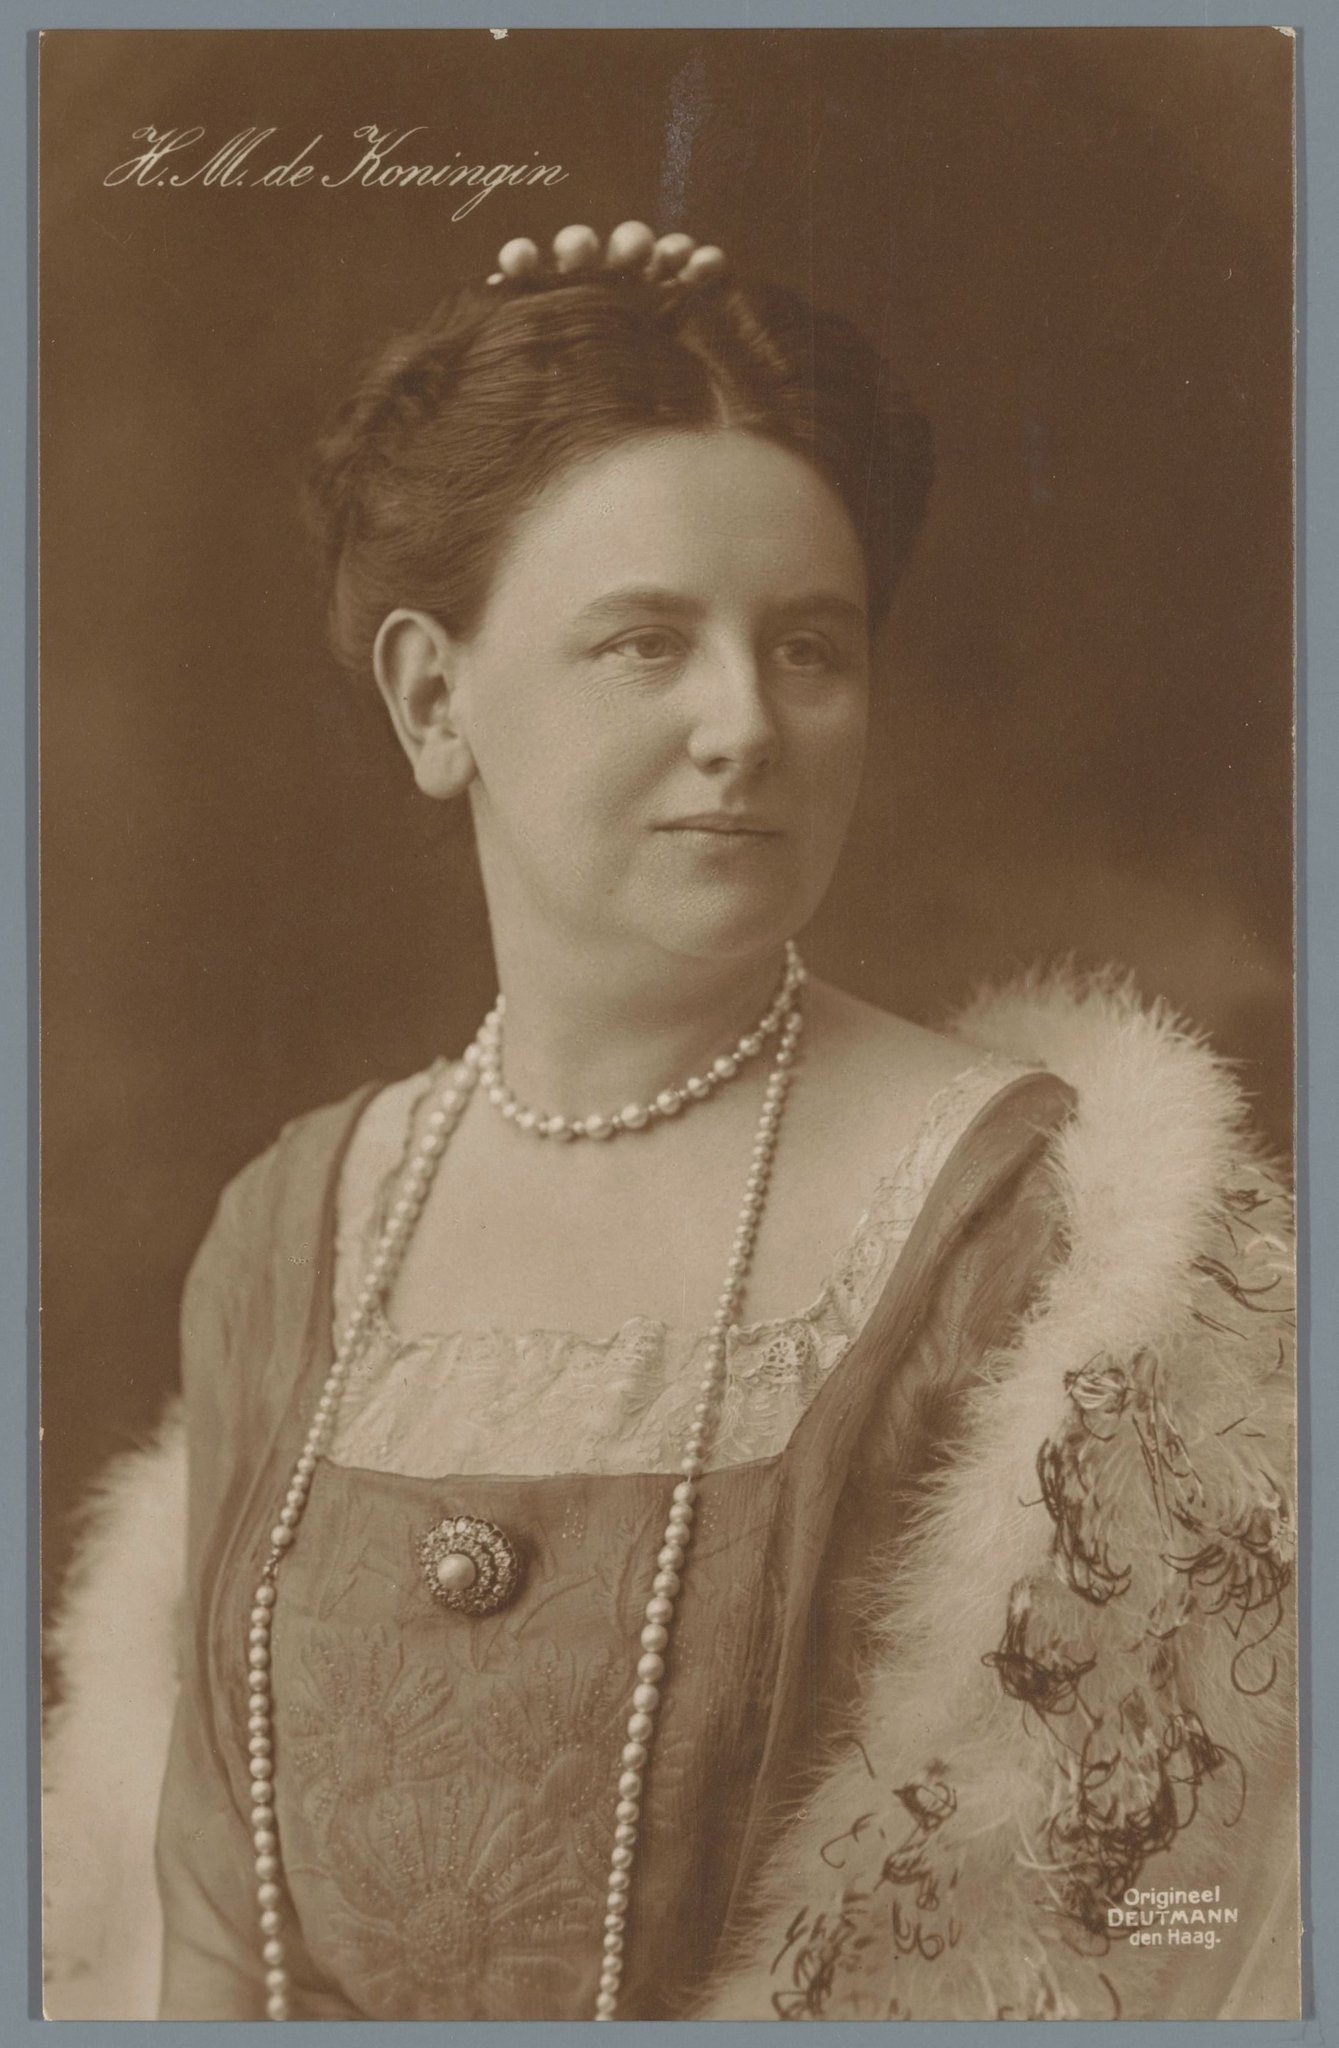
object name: ansichtkaart, prentbriefkaart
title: H.M. de koningin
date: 1912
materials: photographic support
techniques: gelatin silver print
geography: rijswijk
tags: the hague, print maker, wilhelmina of the netherlands, queen, pearl; pearl necklace